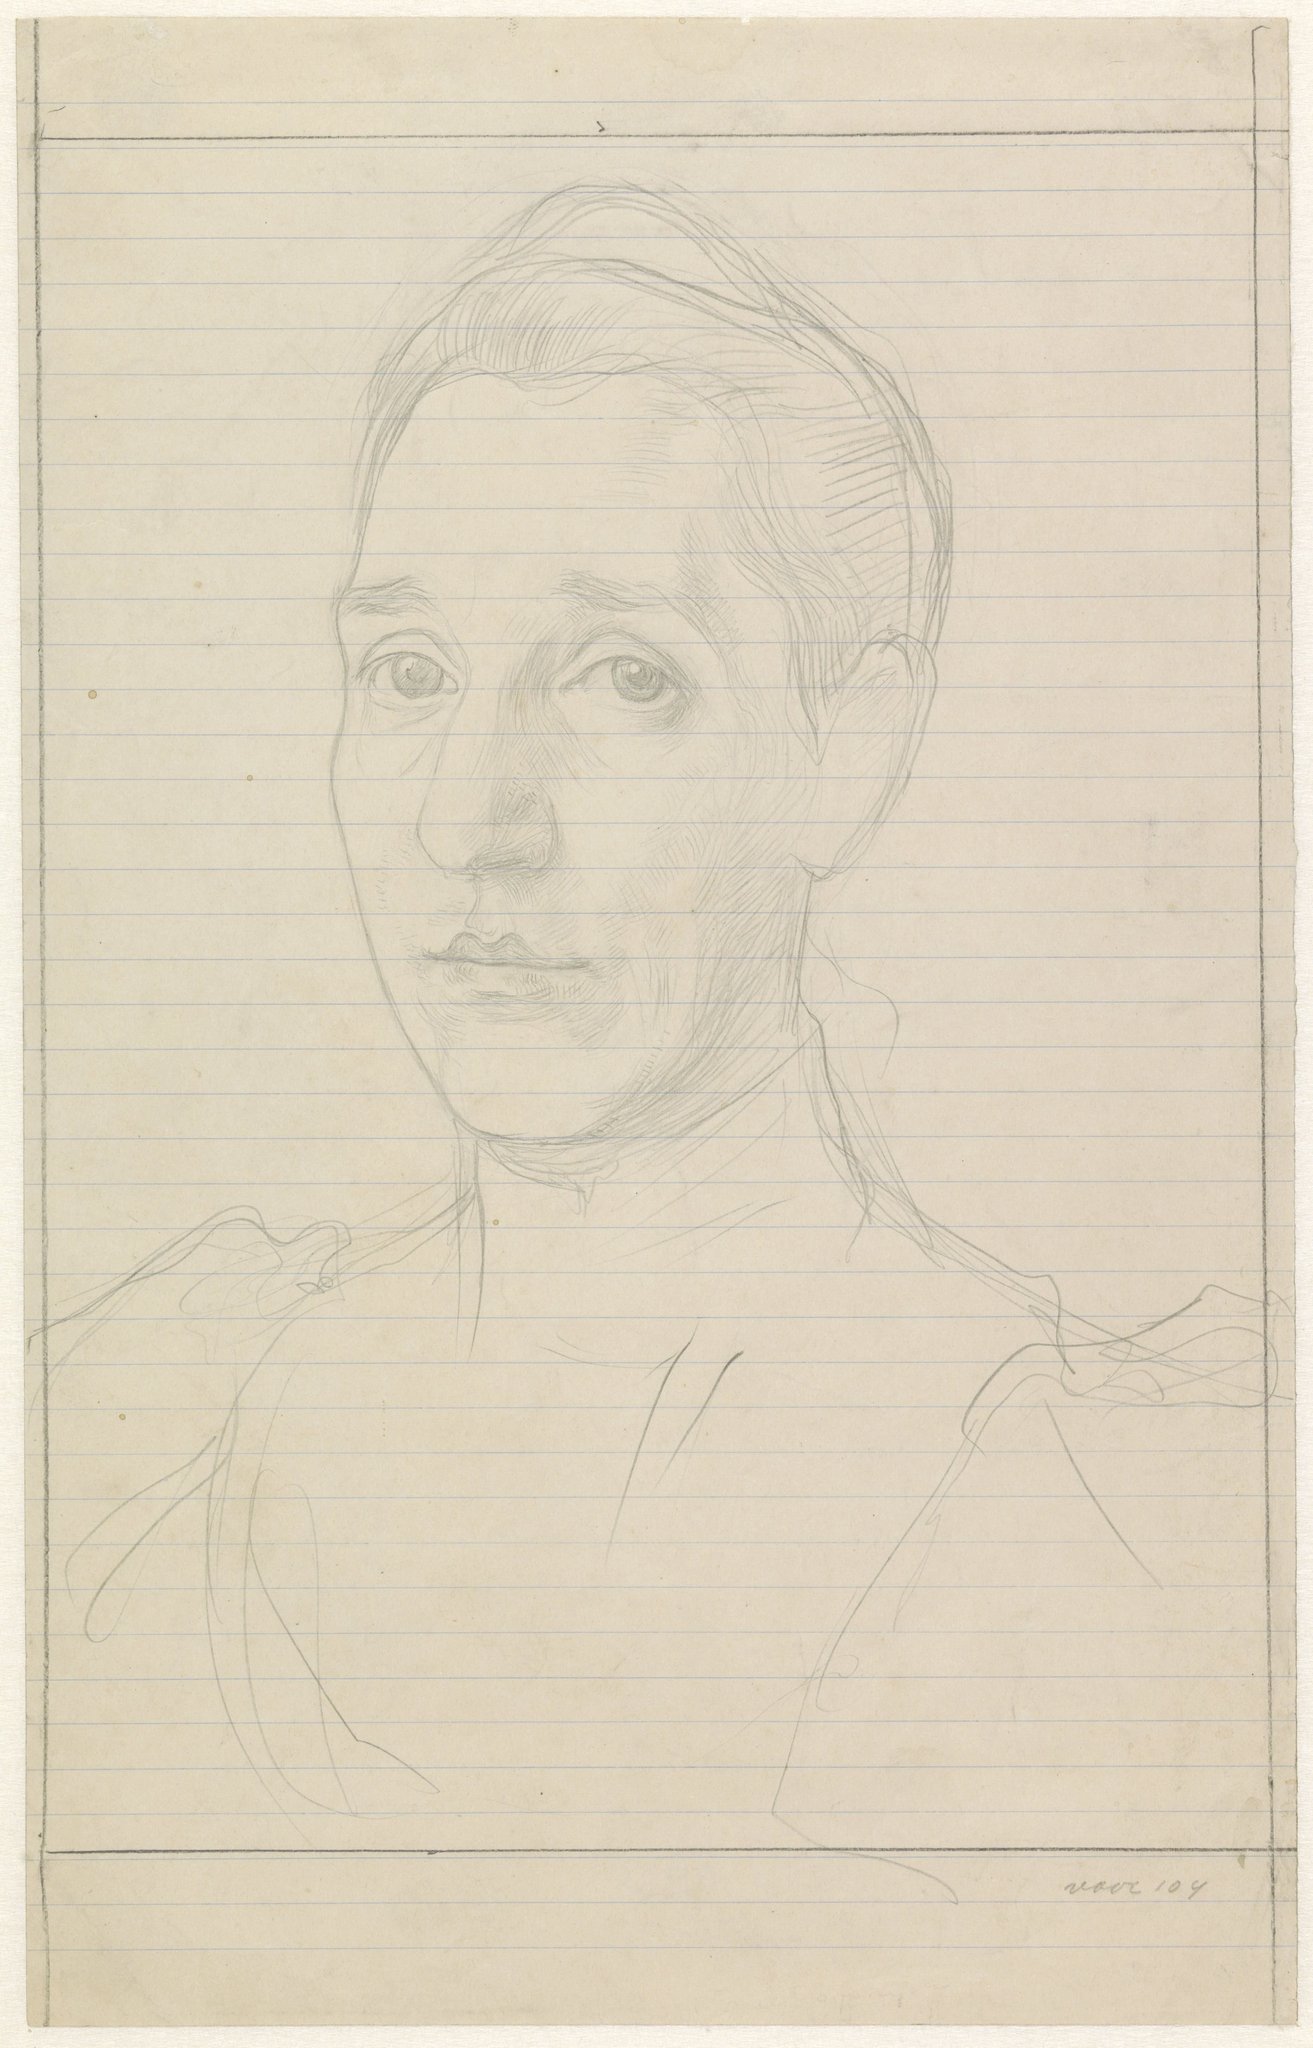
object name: drawing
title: Portret van Anna Dorothea Veth-Dirks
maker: jan veth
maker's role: designer, draughtsman, painter, print maker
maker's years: 1864-1925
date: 1874-1925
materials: paper, pencil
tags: artist, anna dorothea dirks, historical persons